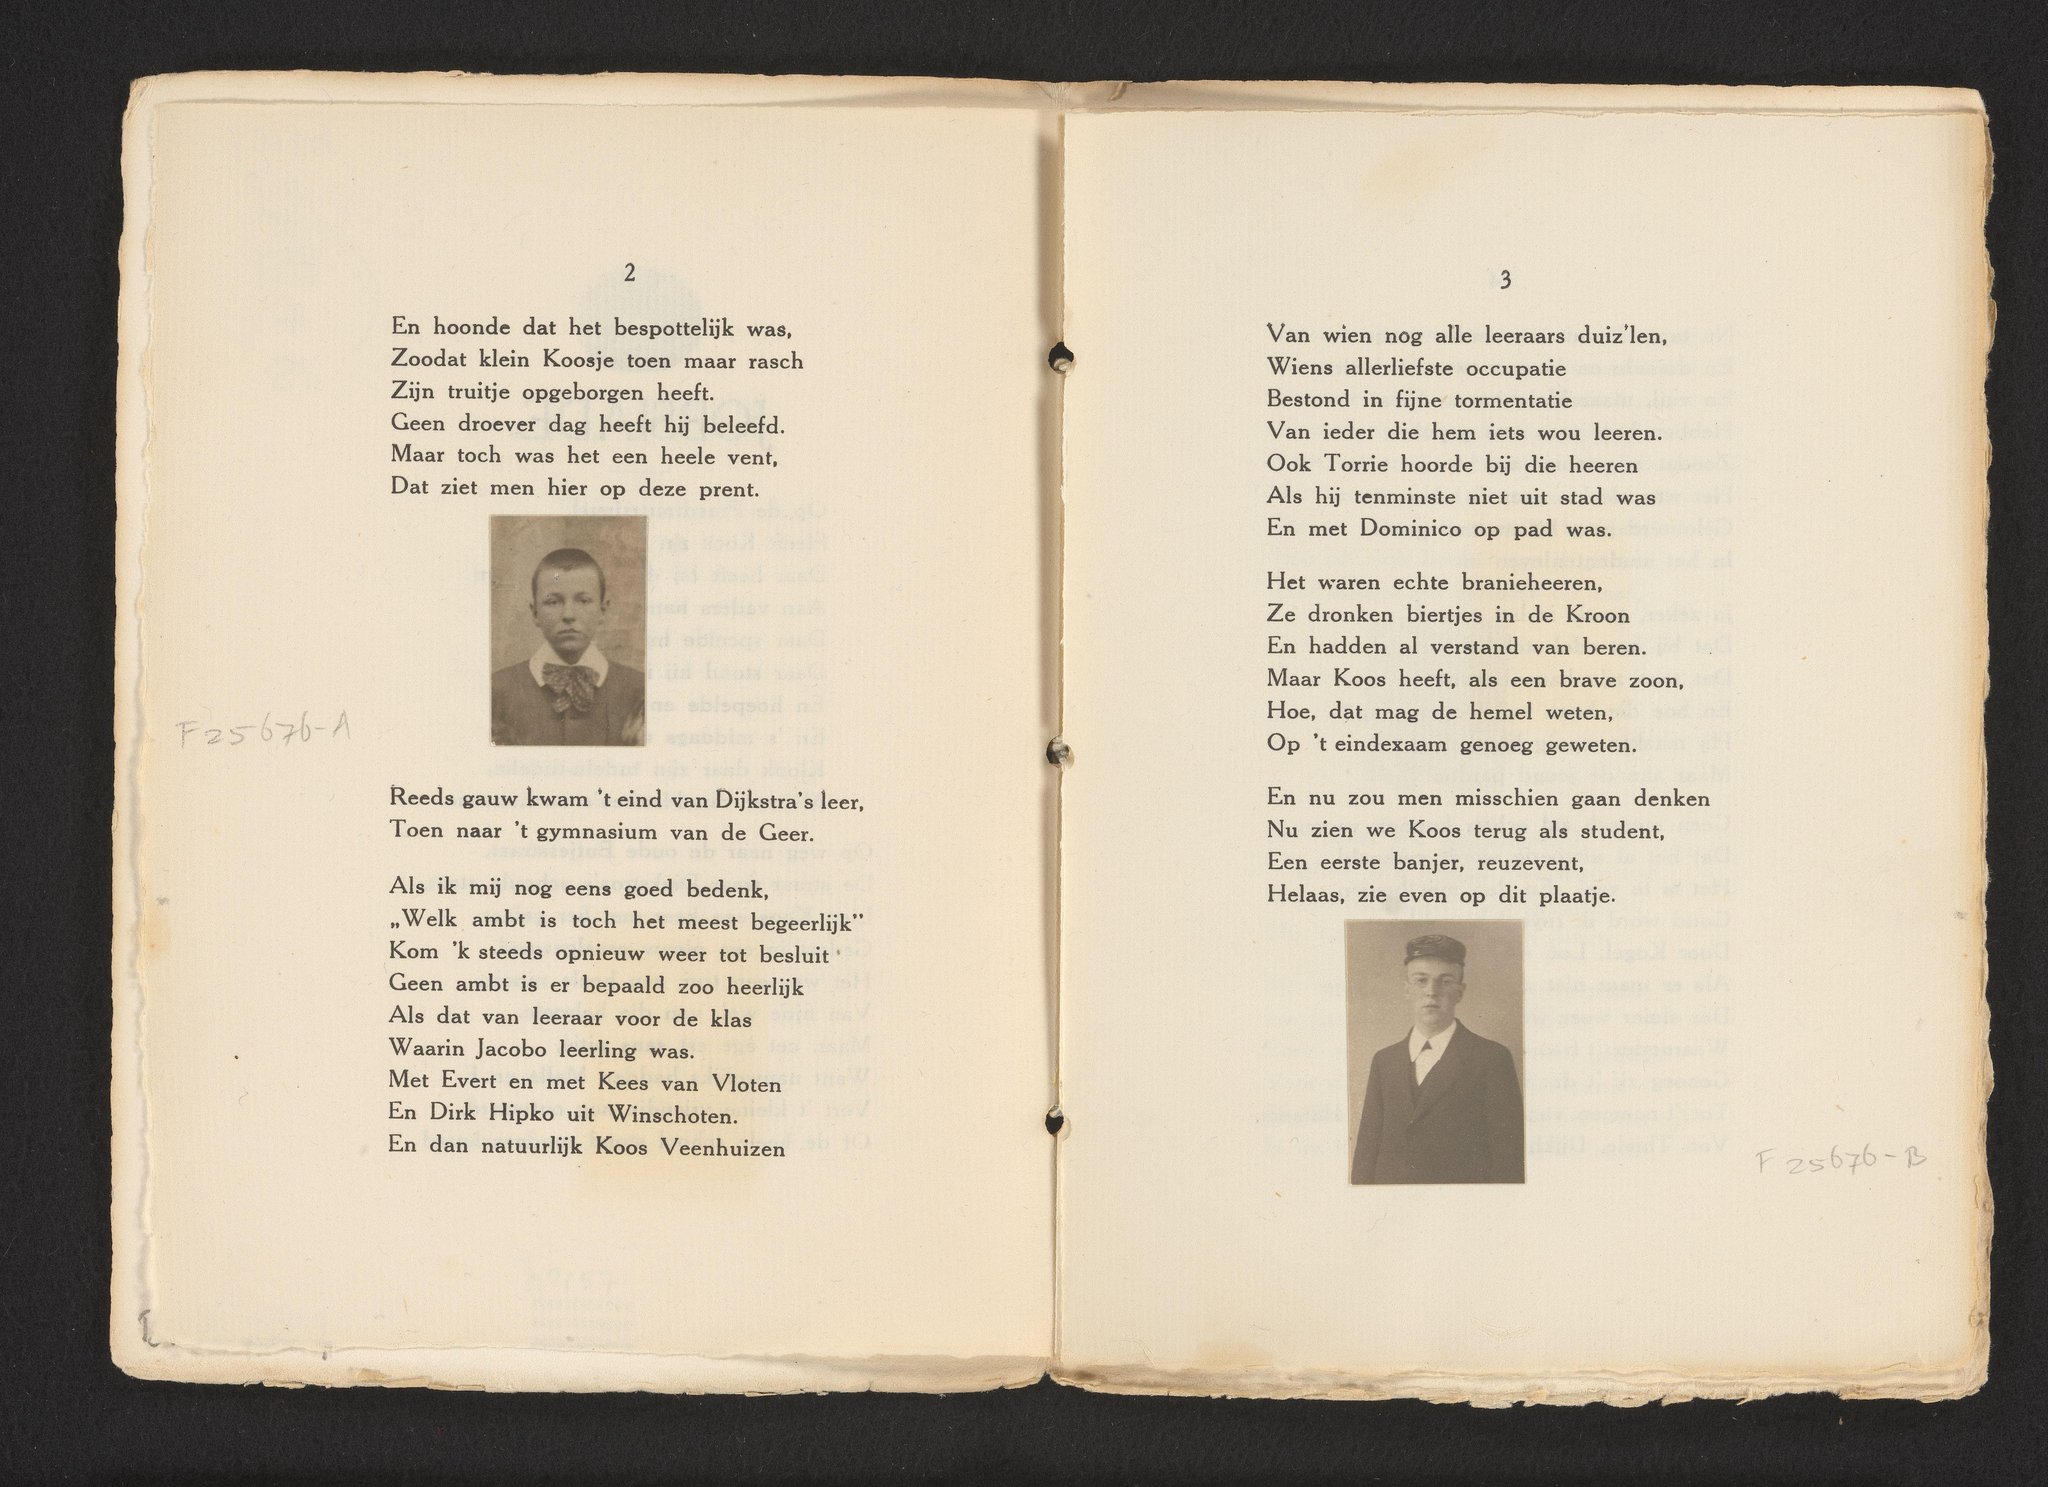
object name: page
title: Portret van Jacobo Willem Bos als student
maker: Anonymous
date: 1910-1920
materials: paper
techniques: gelatin silver print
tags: historical persons, youth, adolescent